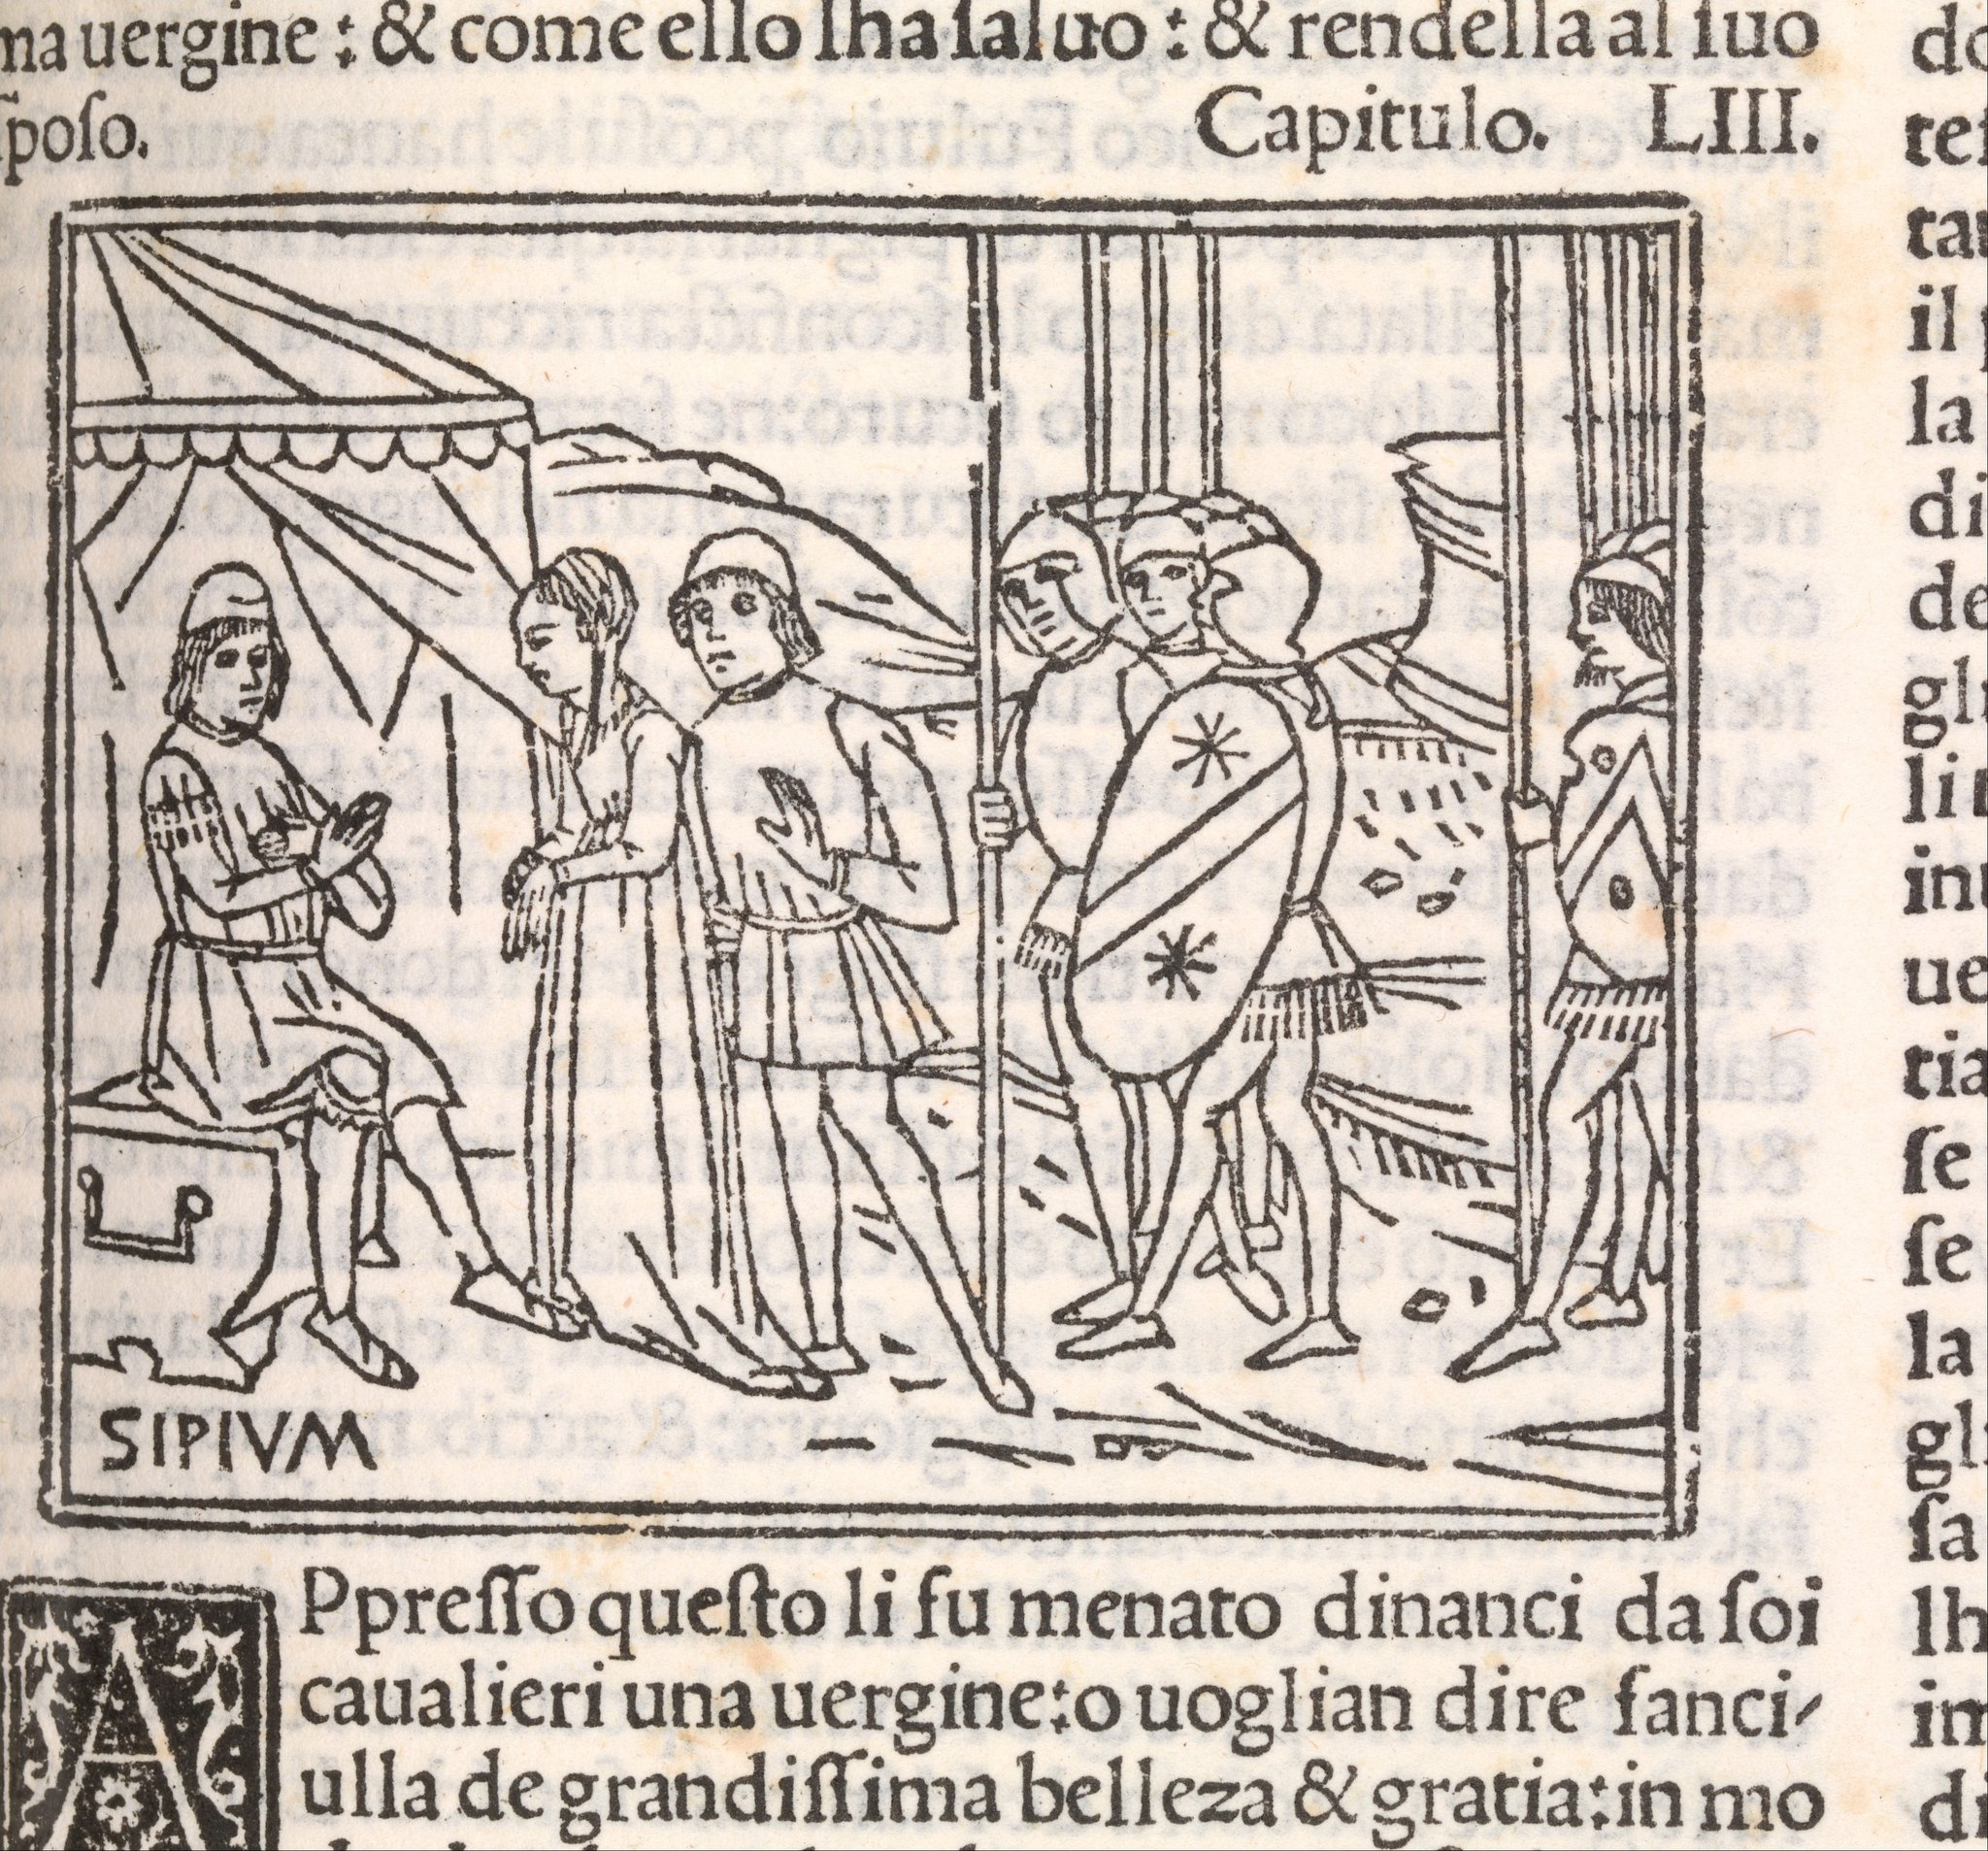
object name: book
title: Deche di Tito Livio vulgare hystoriate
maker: titus livius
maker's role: author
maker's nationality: roman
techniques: printing, woodcut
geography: venice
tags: soldiers,shields,men,women